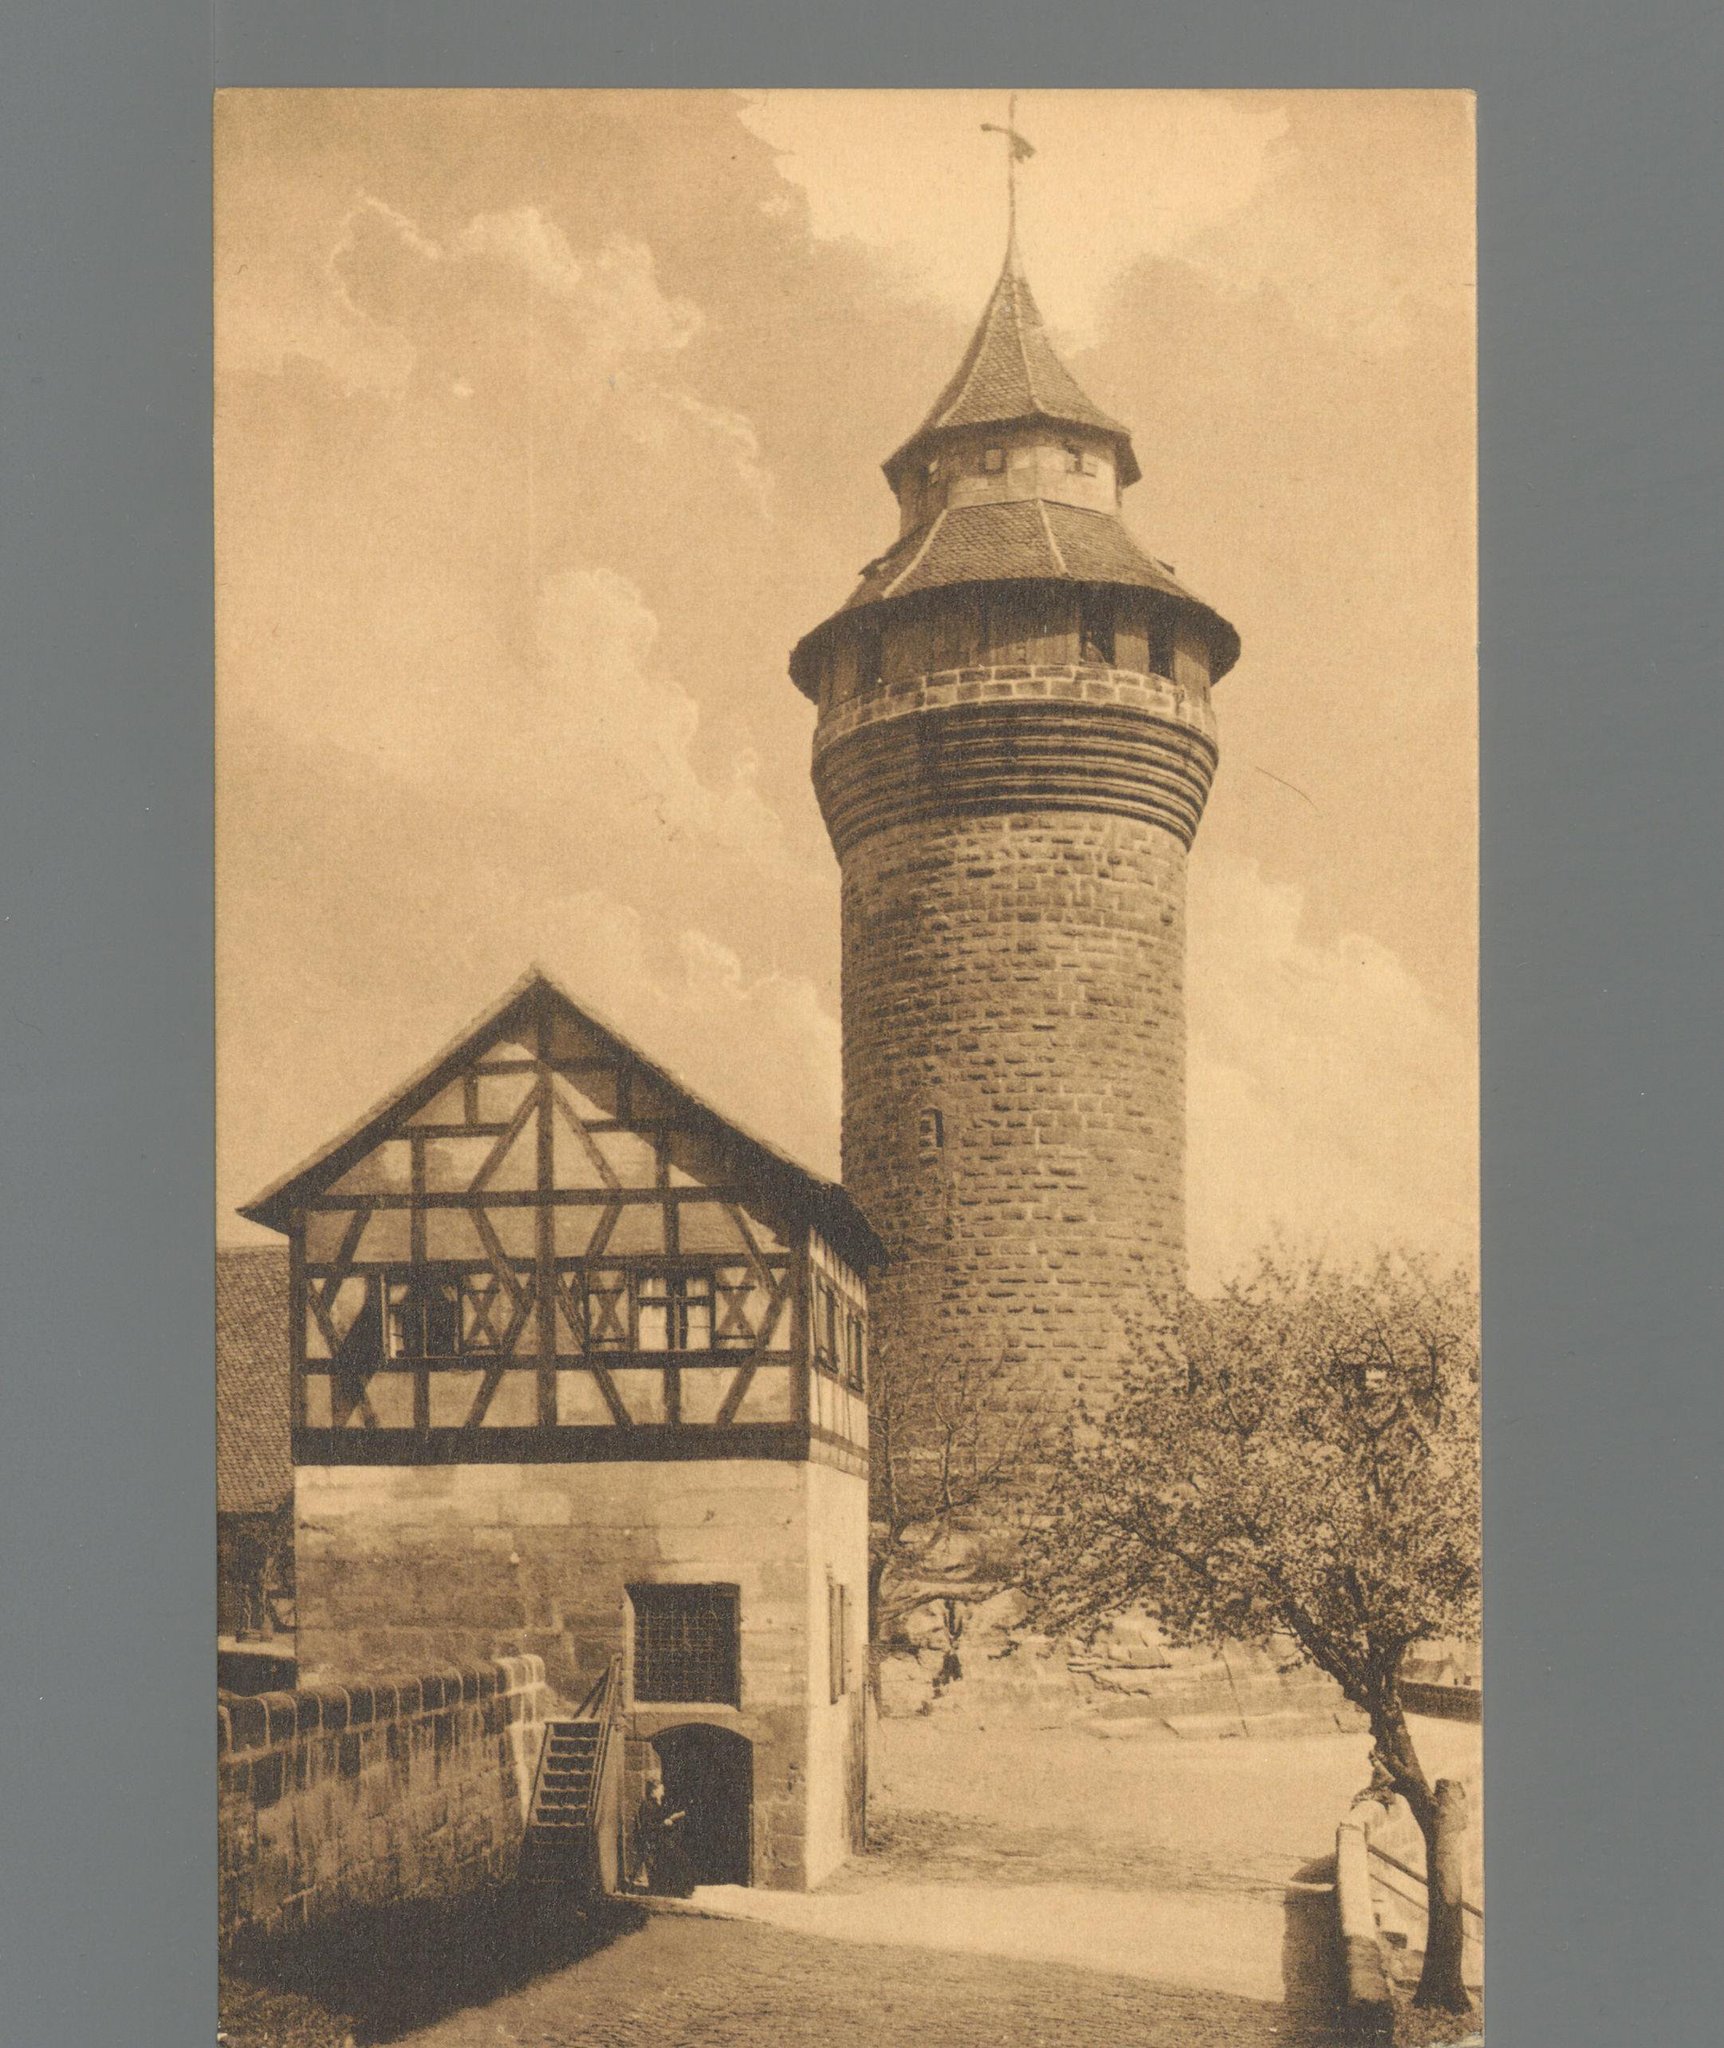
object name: photomechanical print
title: Nürnberg. Vestnerturm u. Tiefer Brunnen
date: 1905-1930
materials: cardboard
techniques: photograph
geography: nuremberg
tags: castle, towers ~ fortified city, ornamental fountain